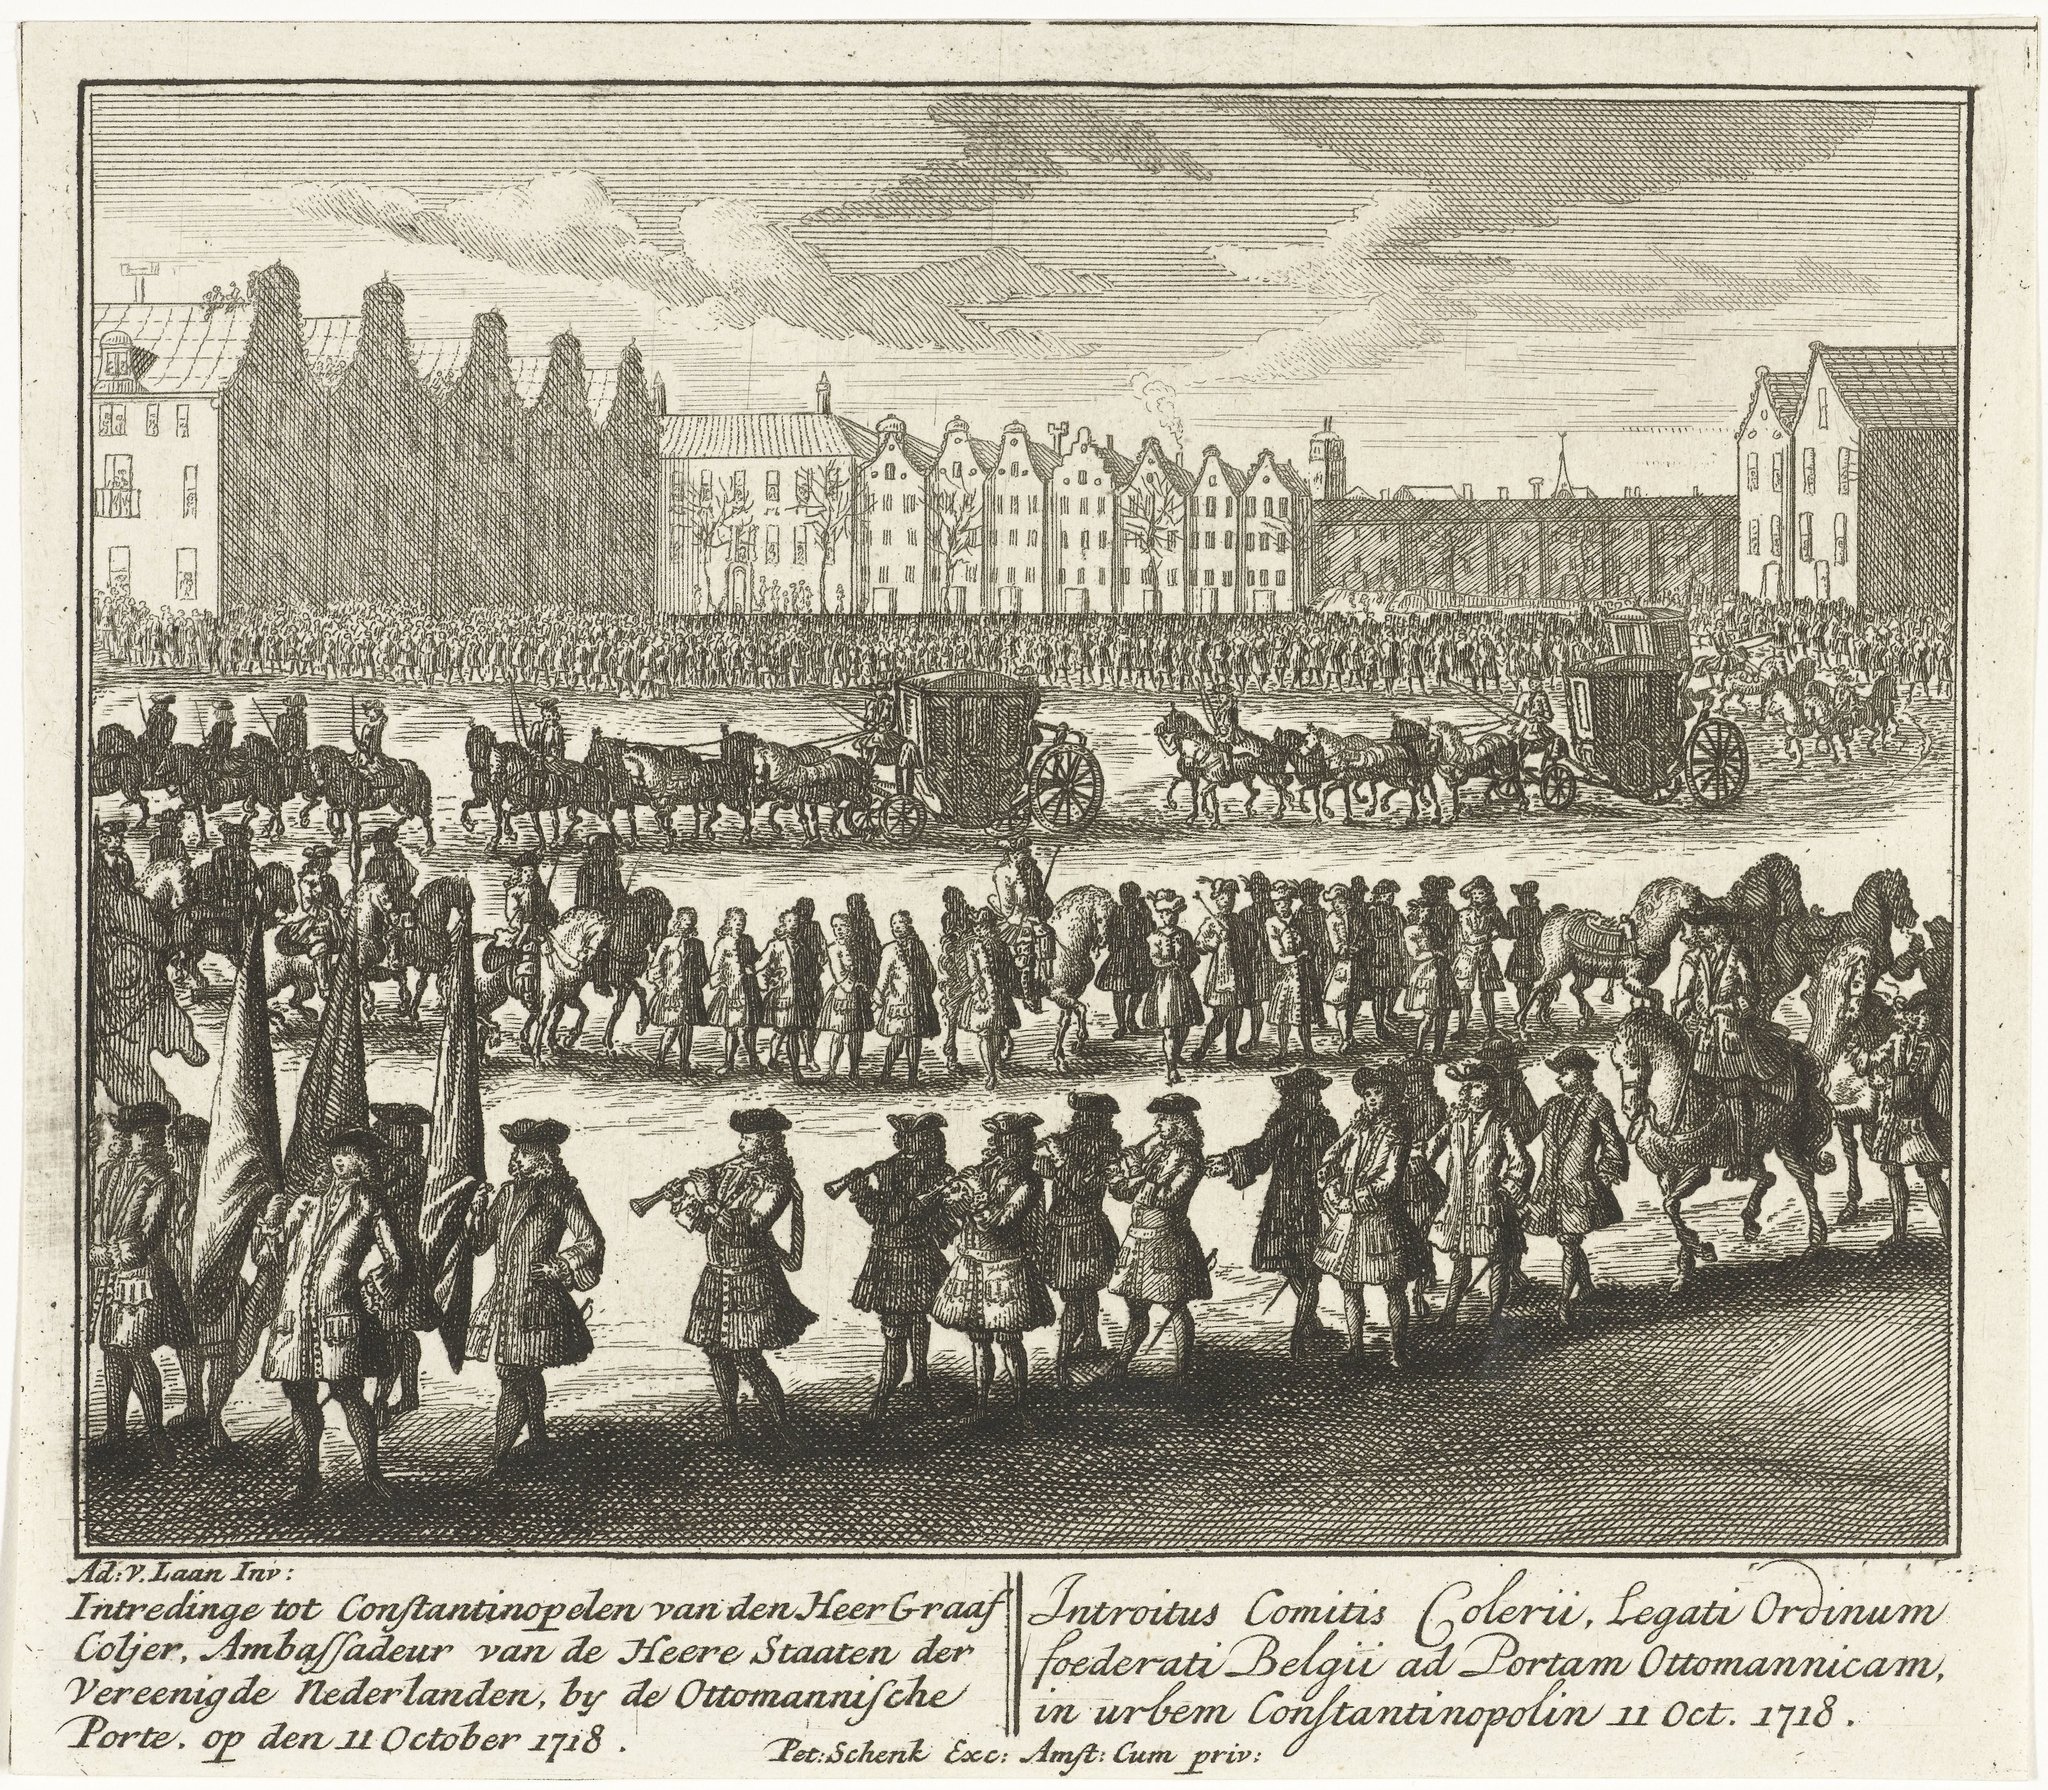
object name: print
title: Intredinge tot Constantinopelen van den Heer Graaf Coljer, Ambassadeur van de Heere Staaten der Vereenigde Nederlanden, by de Ottomannische Porte, op den 11 October 1718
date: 1718-1720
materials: paper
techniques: etching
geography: amsterdam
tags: ceremonial procession, parade, pageant ~ installation of a ruler, audition; ruler giving audience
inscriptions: collector's mark: Lugt 2228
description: Aankomst van de nieuwe Nederlandse ambassadeur Colyer te Constantinopel, 11 oktober 1718. Een lange stoet met muzikanten, militairen en koetsen trekt over het plein. Fragment van een grote plaat met negen voorstellingen van gebeurtenissen uit het jaar 1718 van de Spaanse Successieoorlog.